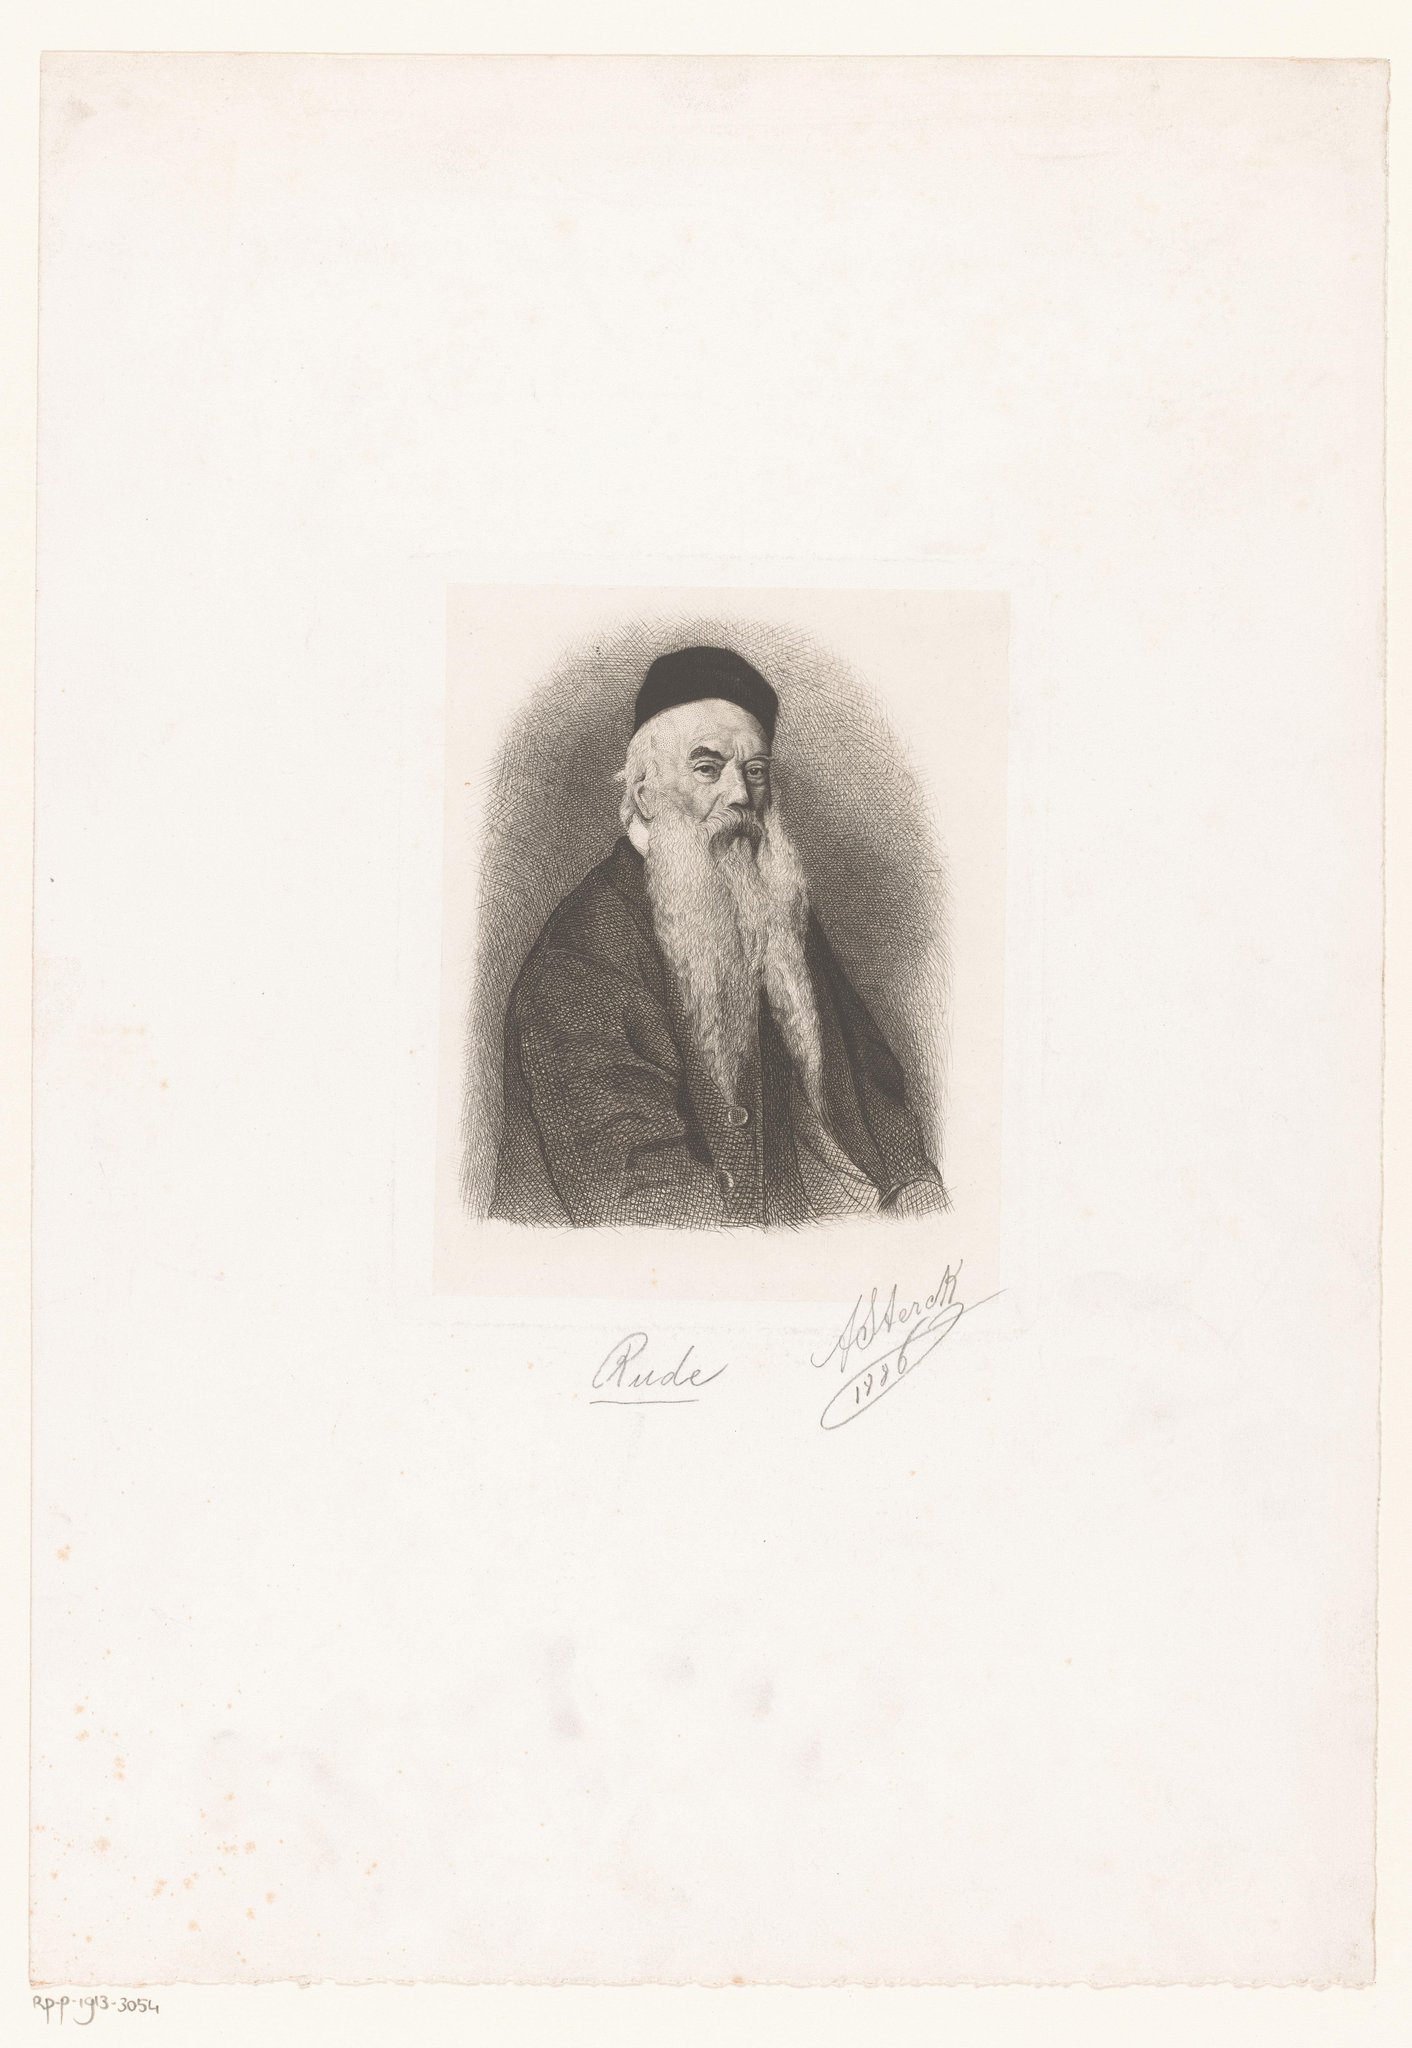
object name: print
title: Portret van François Rude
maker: arthur sterck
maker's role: print maker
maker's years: 1868-1897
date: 1886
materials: paper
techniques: drypoint, etching, intaglio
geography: antwerp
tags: sculptor, françois rude, portrait, self-portrait of sculptor, historical persons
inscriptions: collector's mark: Lugt 2228